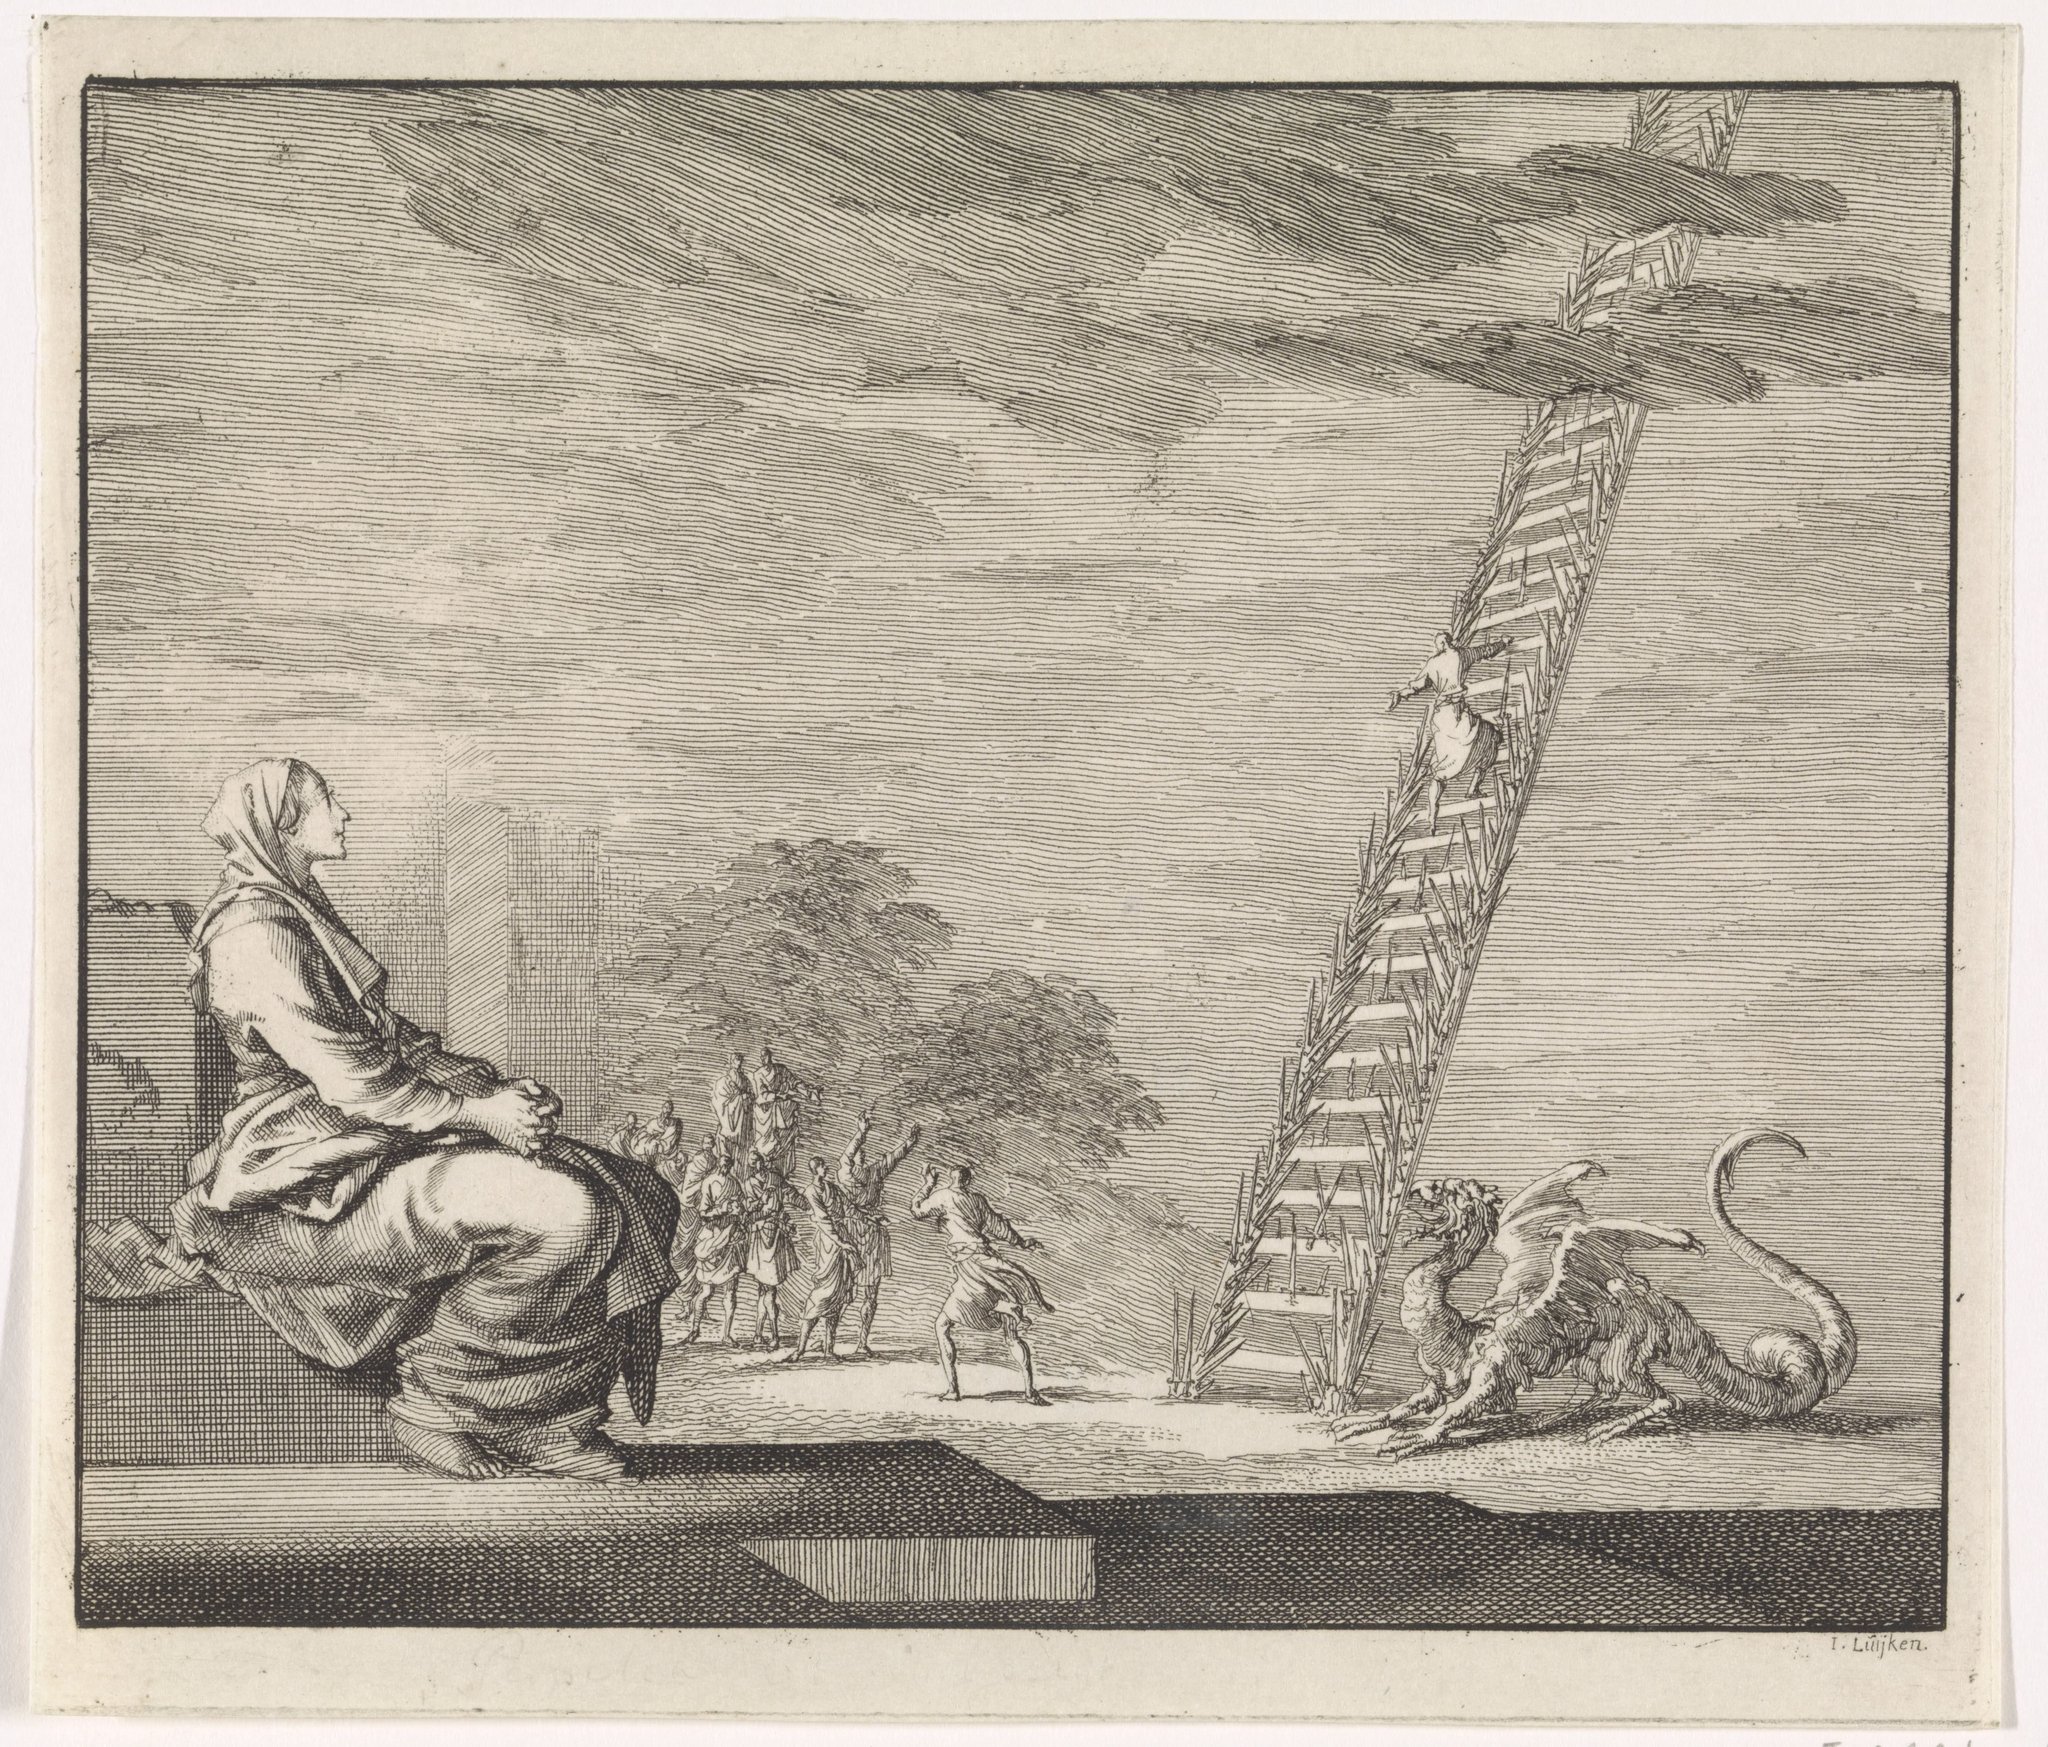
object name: print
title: Visioen van de heilige Perpetua over een ladder naar de hemel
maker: jan luyken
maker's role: draughtsman, print maker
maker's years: 1649-1712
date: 1701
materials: paper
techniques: etching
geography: amsterdam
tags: the early christian churches, e.g. armenians, copts, syrians, the martyrs perpetua and felicitas (felicity) of carthage; possible attributes: wild bull - vision(s), mystic marriage of female saint, dragon, vision, ladder, stairway to heaven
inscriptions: collector's mark: Lugt 2228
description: De H. Perpetua zit op de voorgrond en heeft een visioen. Ze ziet een ladder, gemaakt van zwaarden en lansen, die naar de hemel reikt. Mensen proberen te ladder te beklimmen. Onder aan de ladder ligt een draak die diegenen die naar beneden vallen zal verslinden.